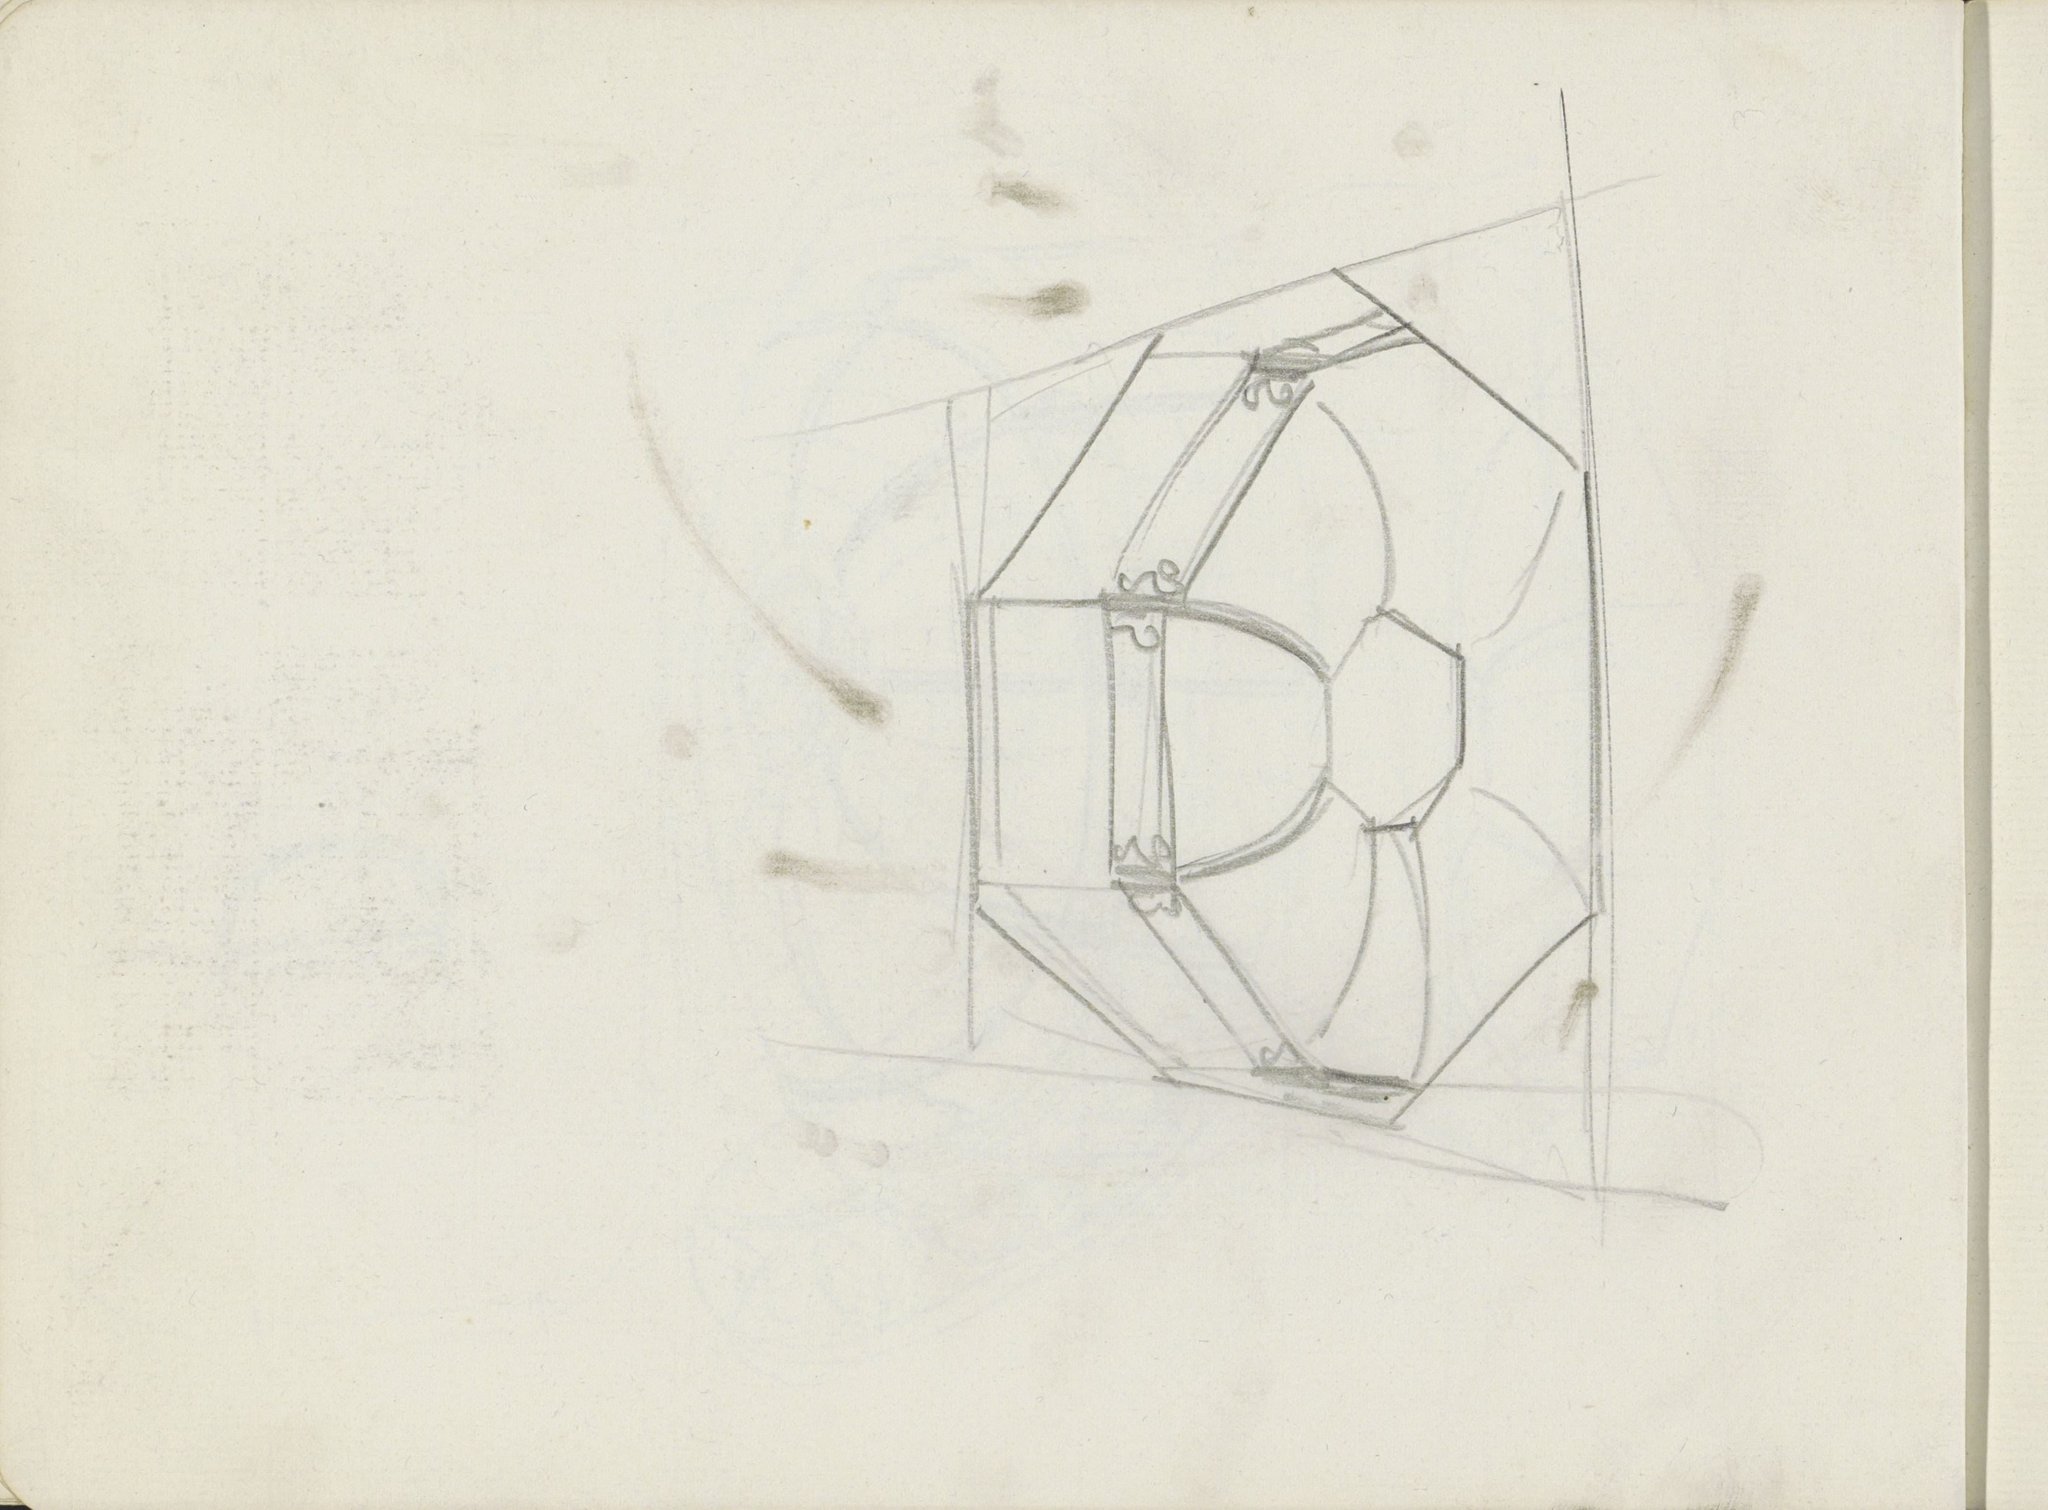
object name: sketchbook leaf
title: Studie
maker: carel adolph lion cachet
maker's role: draughtsman, print maker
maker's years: 1864-1945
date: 1905-1910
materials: paper, pencil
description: Blad 22 verso uit een schetsboek met 27 bladen.